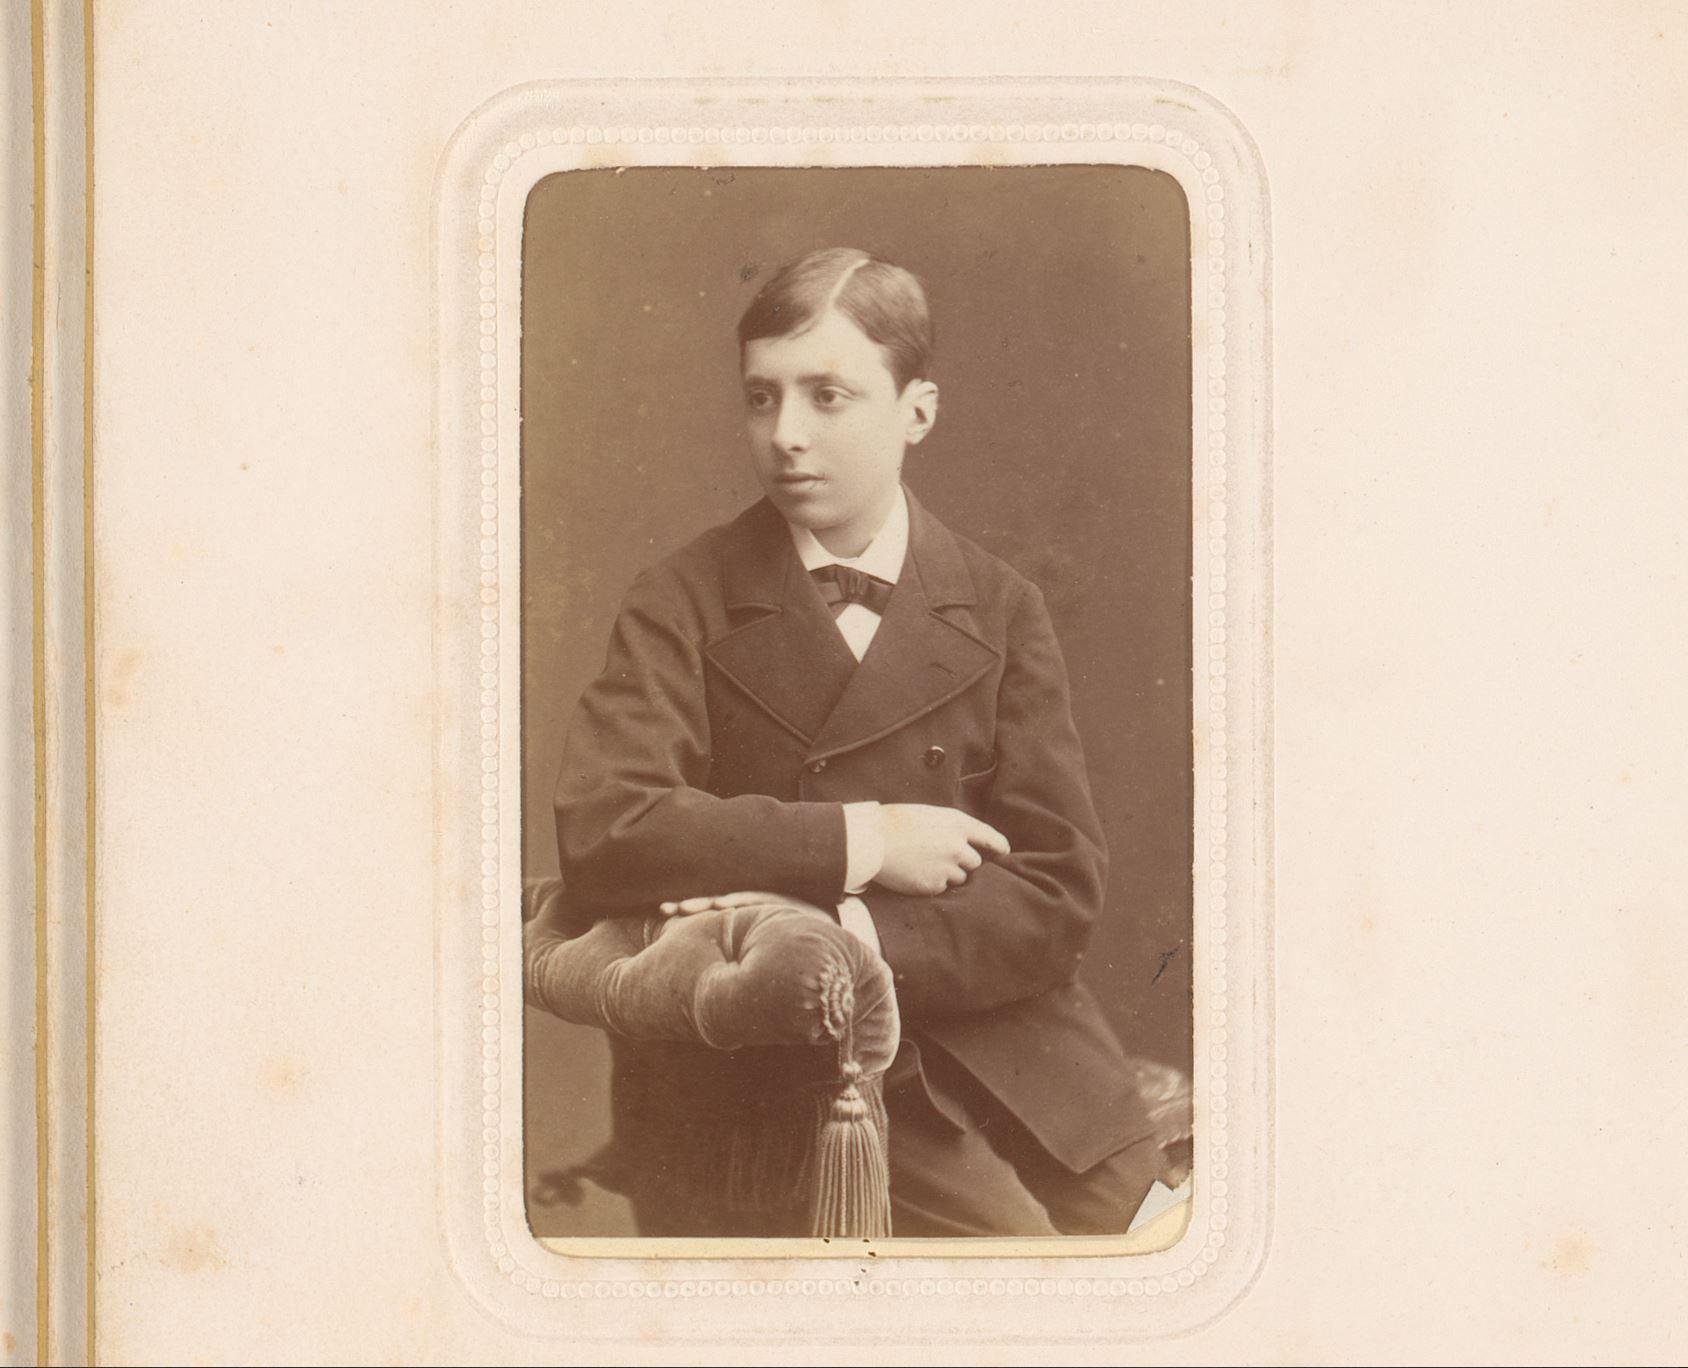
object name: album leaf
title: Portret van een zittende jonge man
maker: michel berthaud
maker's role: publisher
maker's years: 1845-1912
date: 1860-1890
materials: cardboard, photographic support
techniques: albumen print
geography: paris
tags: sitting figure, historical persons, youth, adolescent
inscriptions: inscription: ‘9 Rue Cadet, Paris’